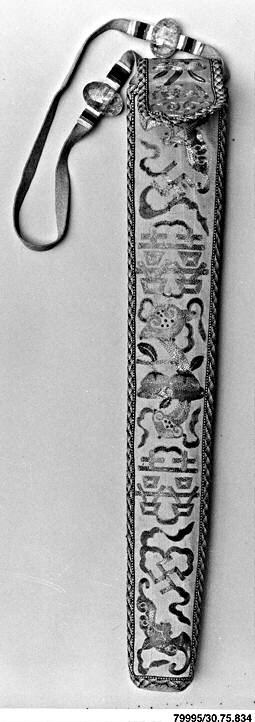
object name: fan holder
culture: chinese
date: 1701-1900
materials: quartz, silk